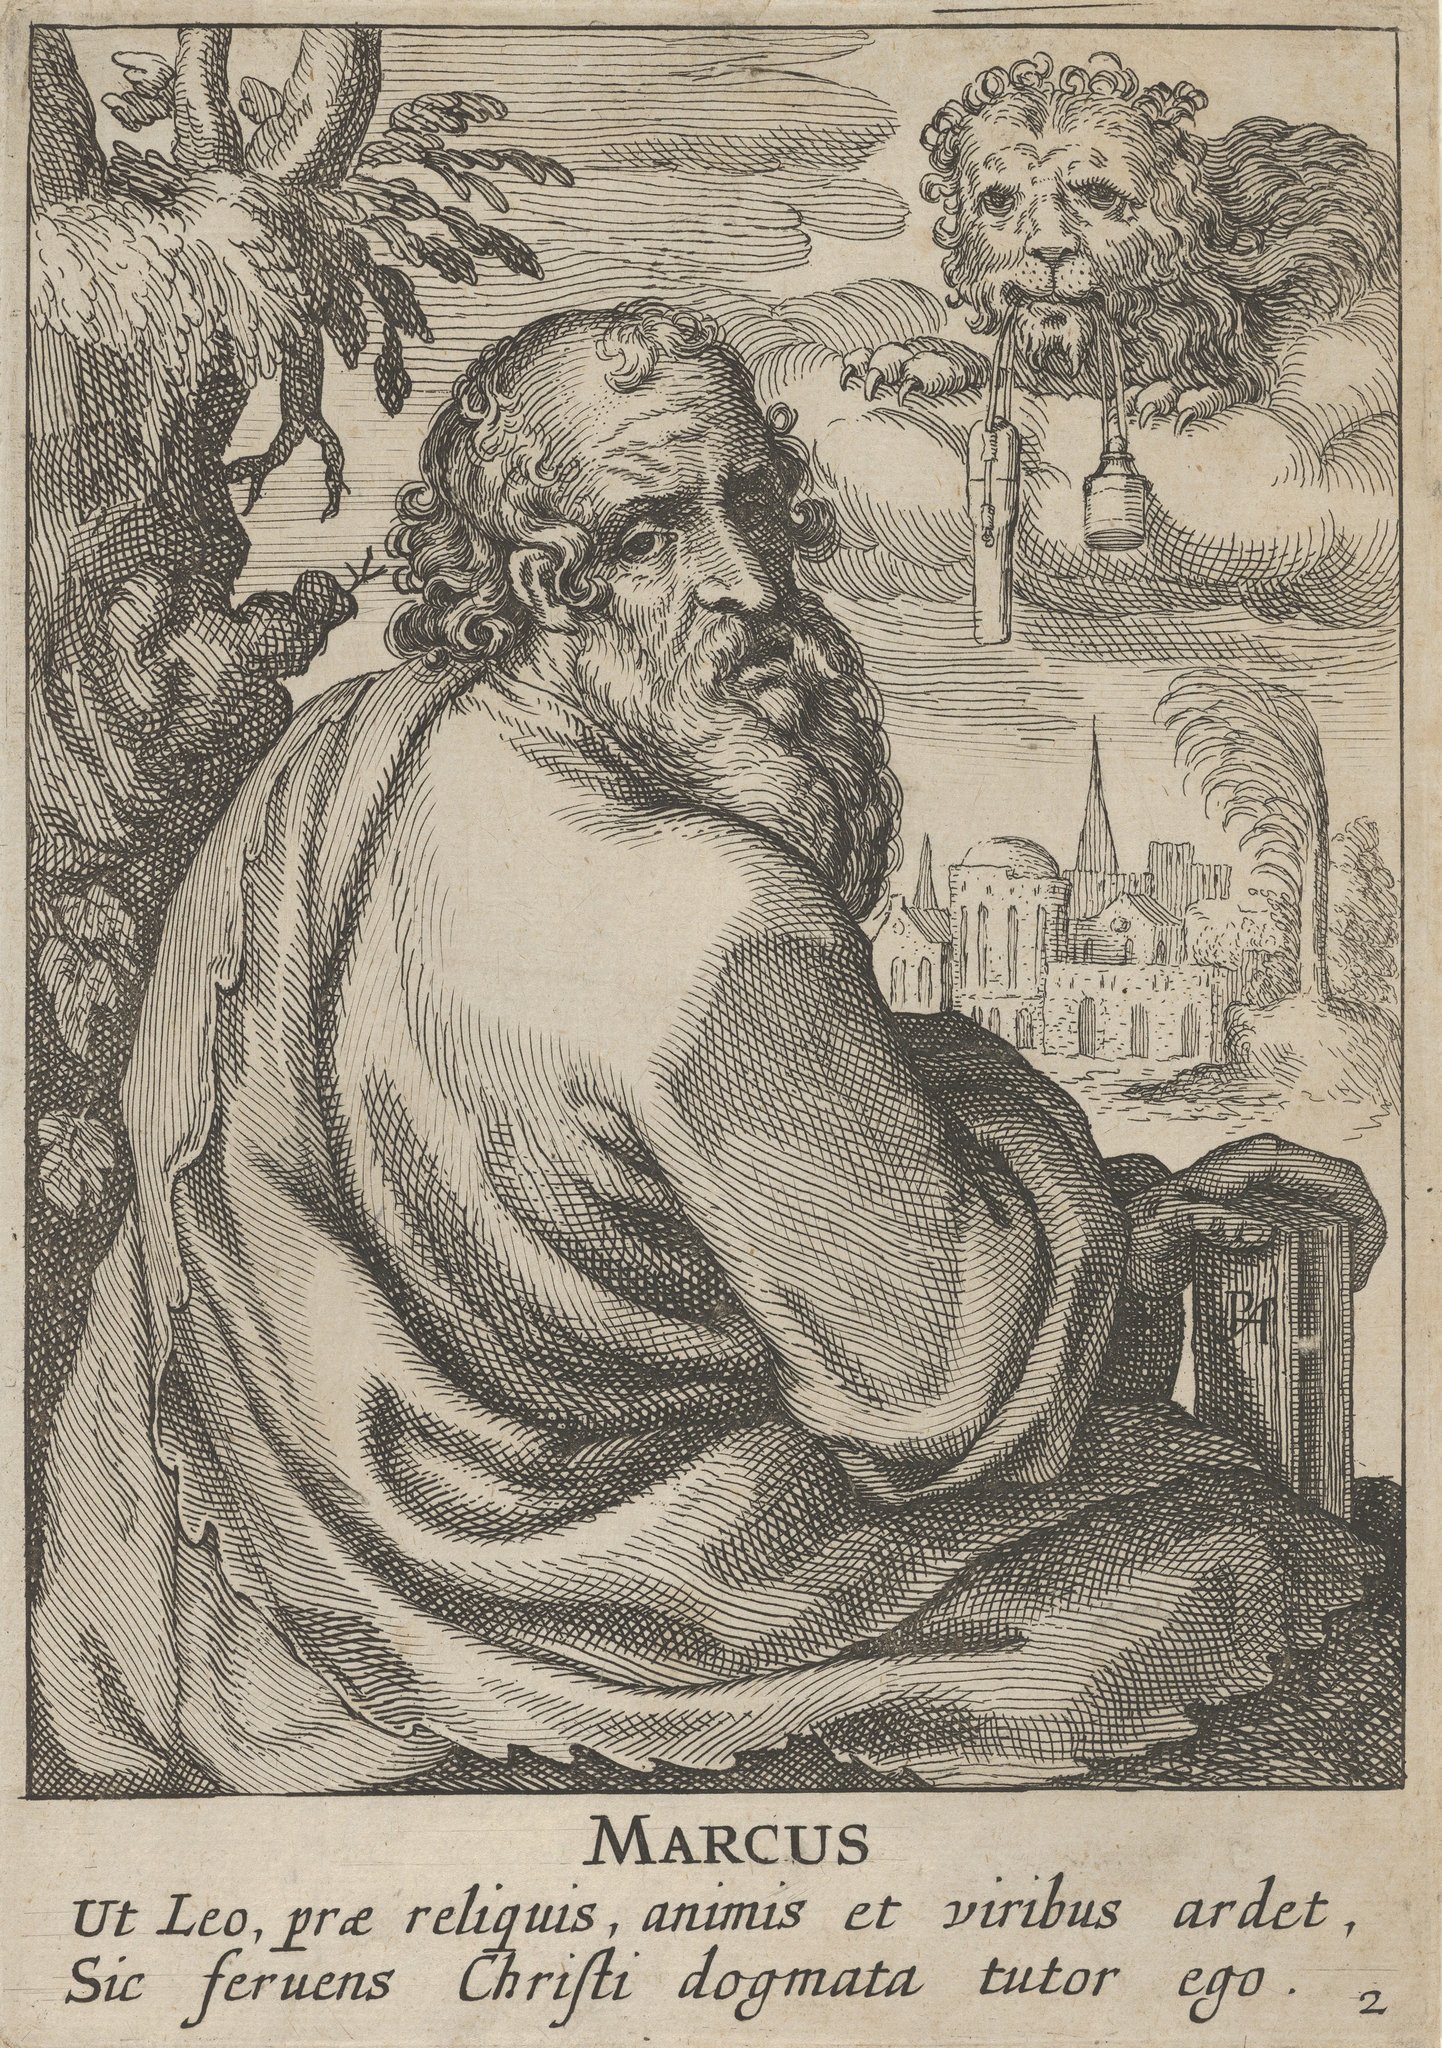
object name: print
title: Mark, from The Four Evangelists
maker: pieter feddes van harlingen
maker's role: artist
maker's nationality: dutch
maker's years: 1614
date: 1610-1620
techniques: etching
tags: books,saint mark